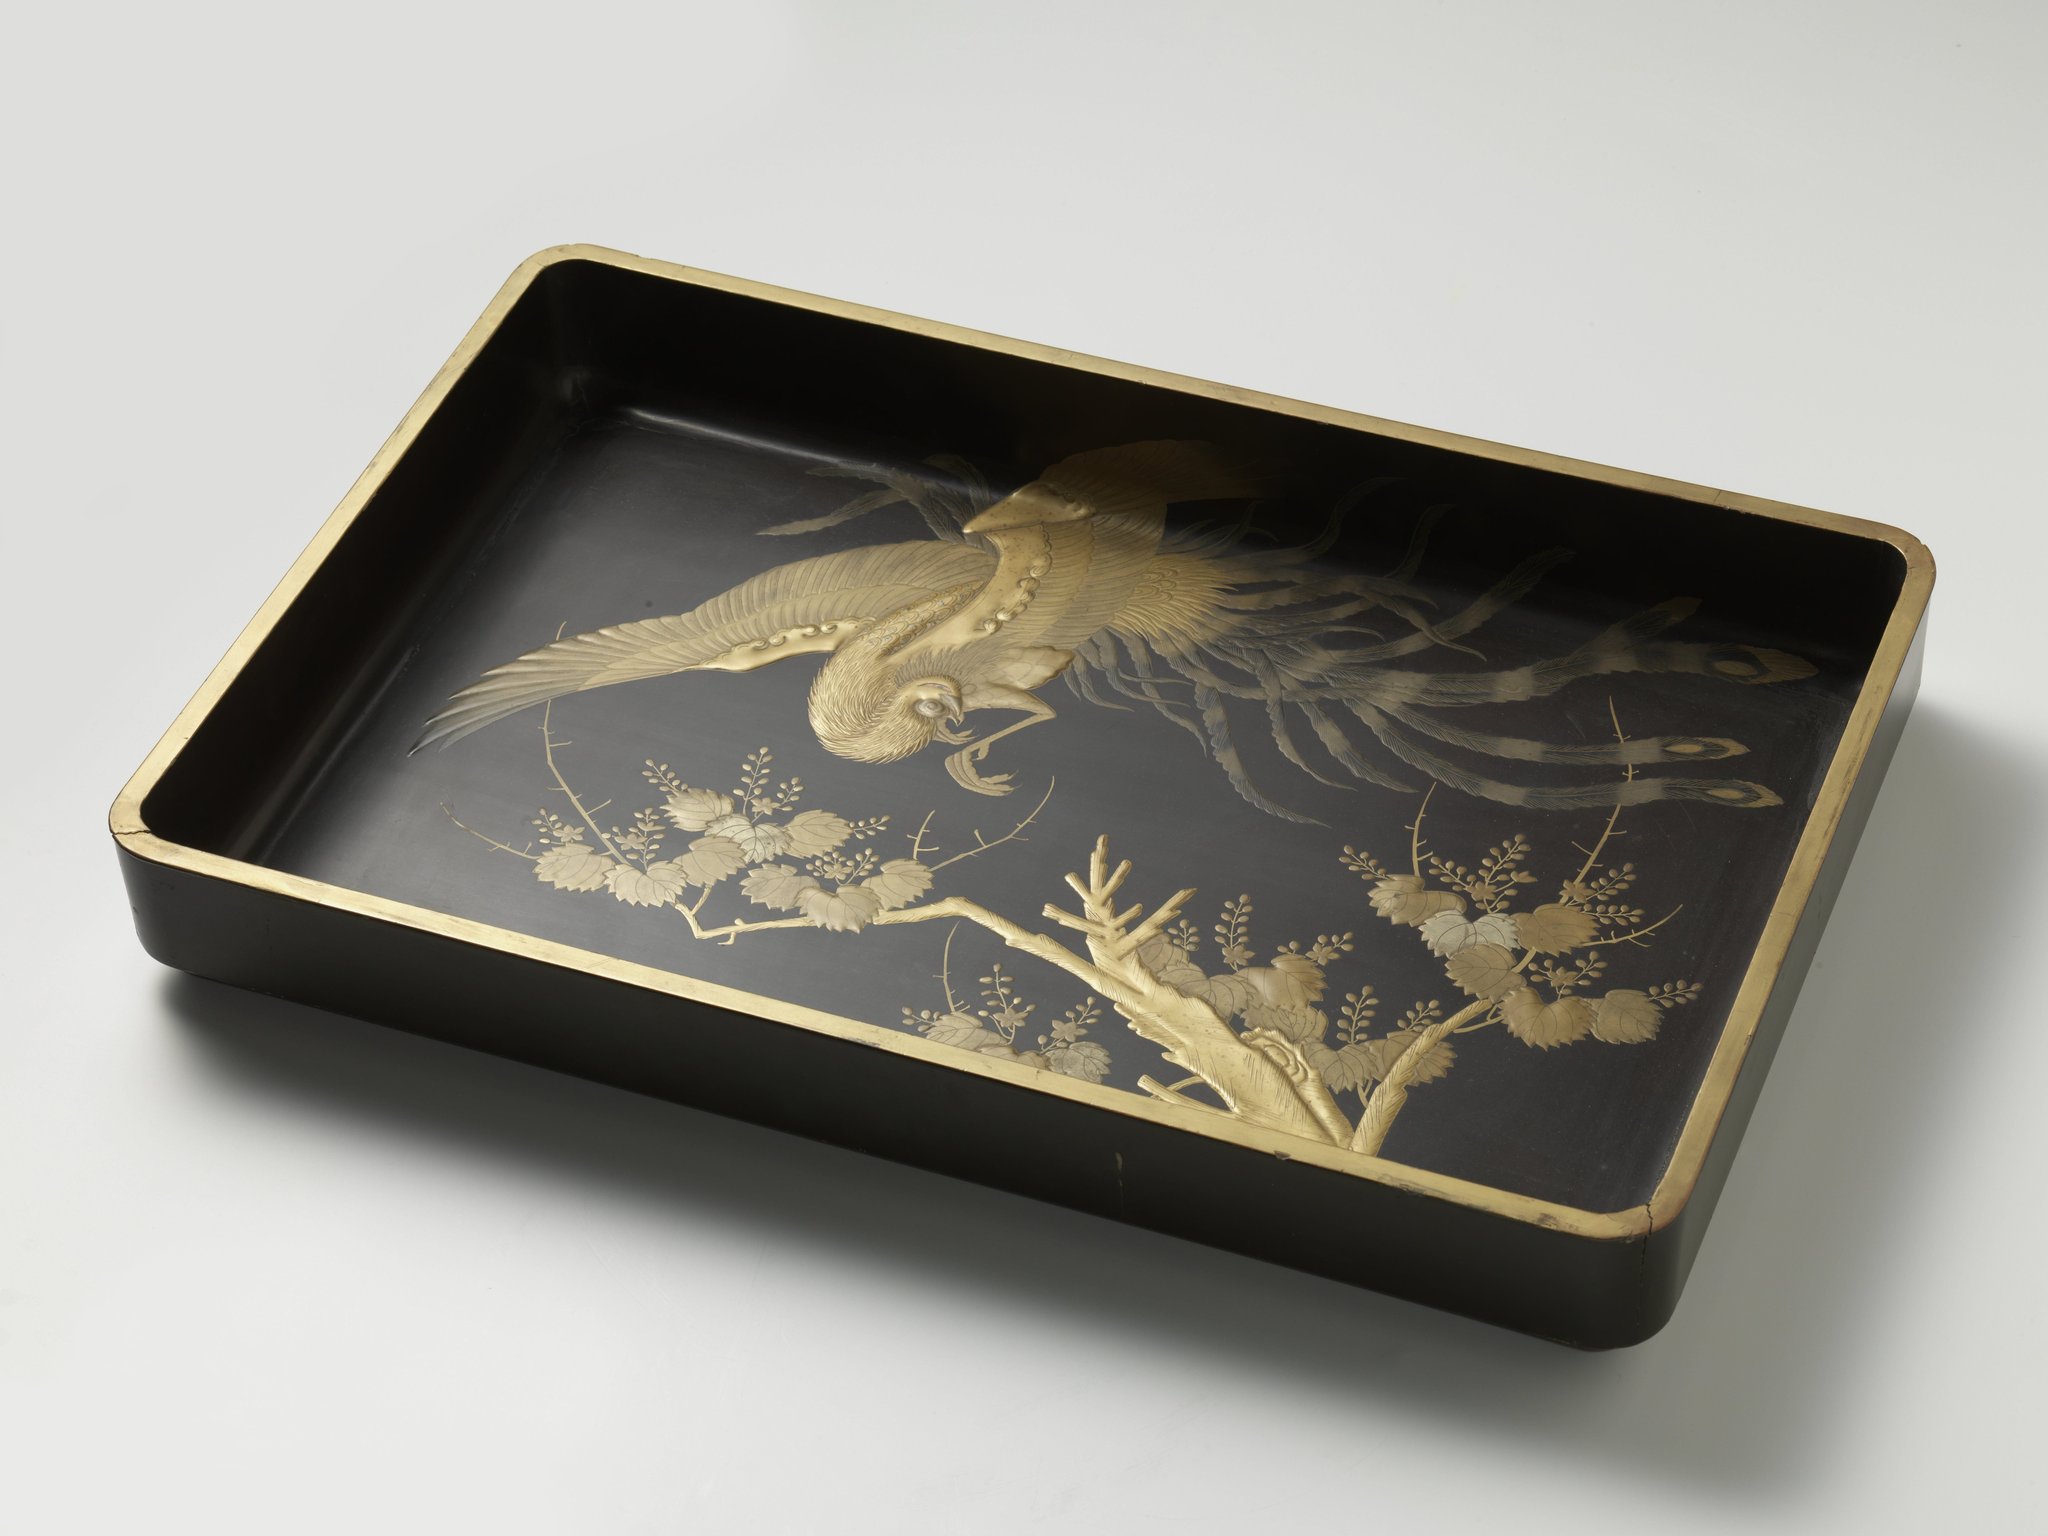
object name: dienblad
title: Tray with a Hoo-Bird and Paulownia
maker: Anonymous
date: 1700-1800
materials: gold, lacquer, mother of pearl, wood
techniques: lacquer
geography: japan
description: The hoo is derived from the Chinese fenghuang and is one of the Four Devine Creatures, together with the dragon, the qilin, and the turtle. Like the shishi, the hoo is a mythical creature known as the bearer of great fortune.